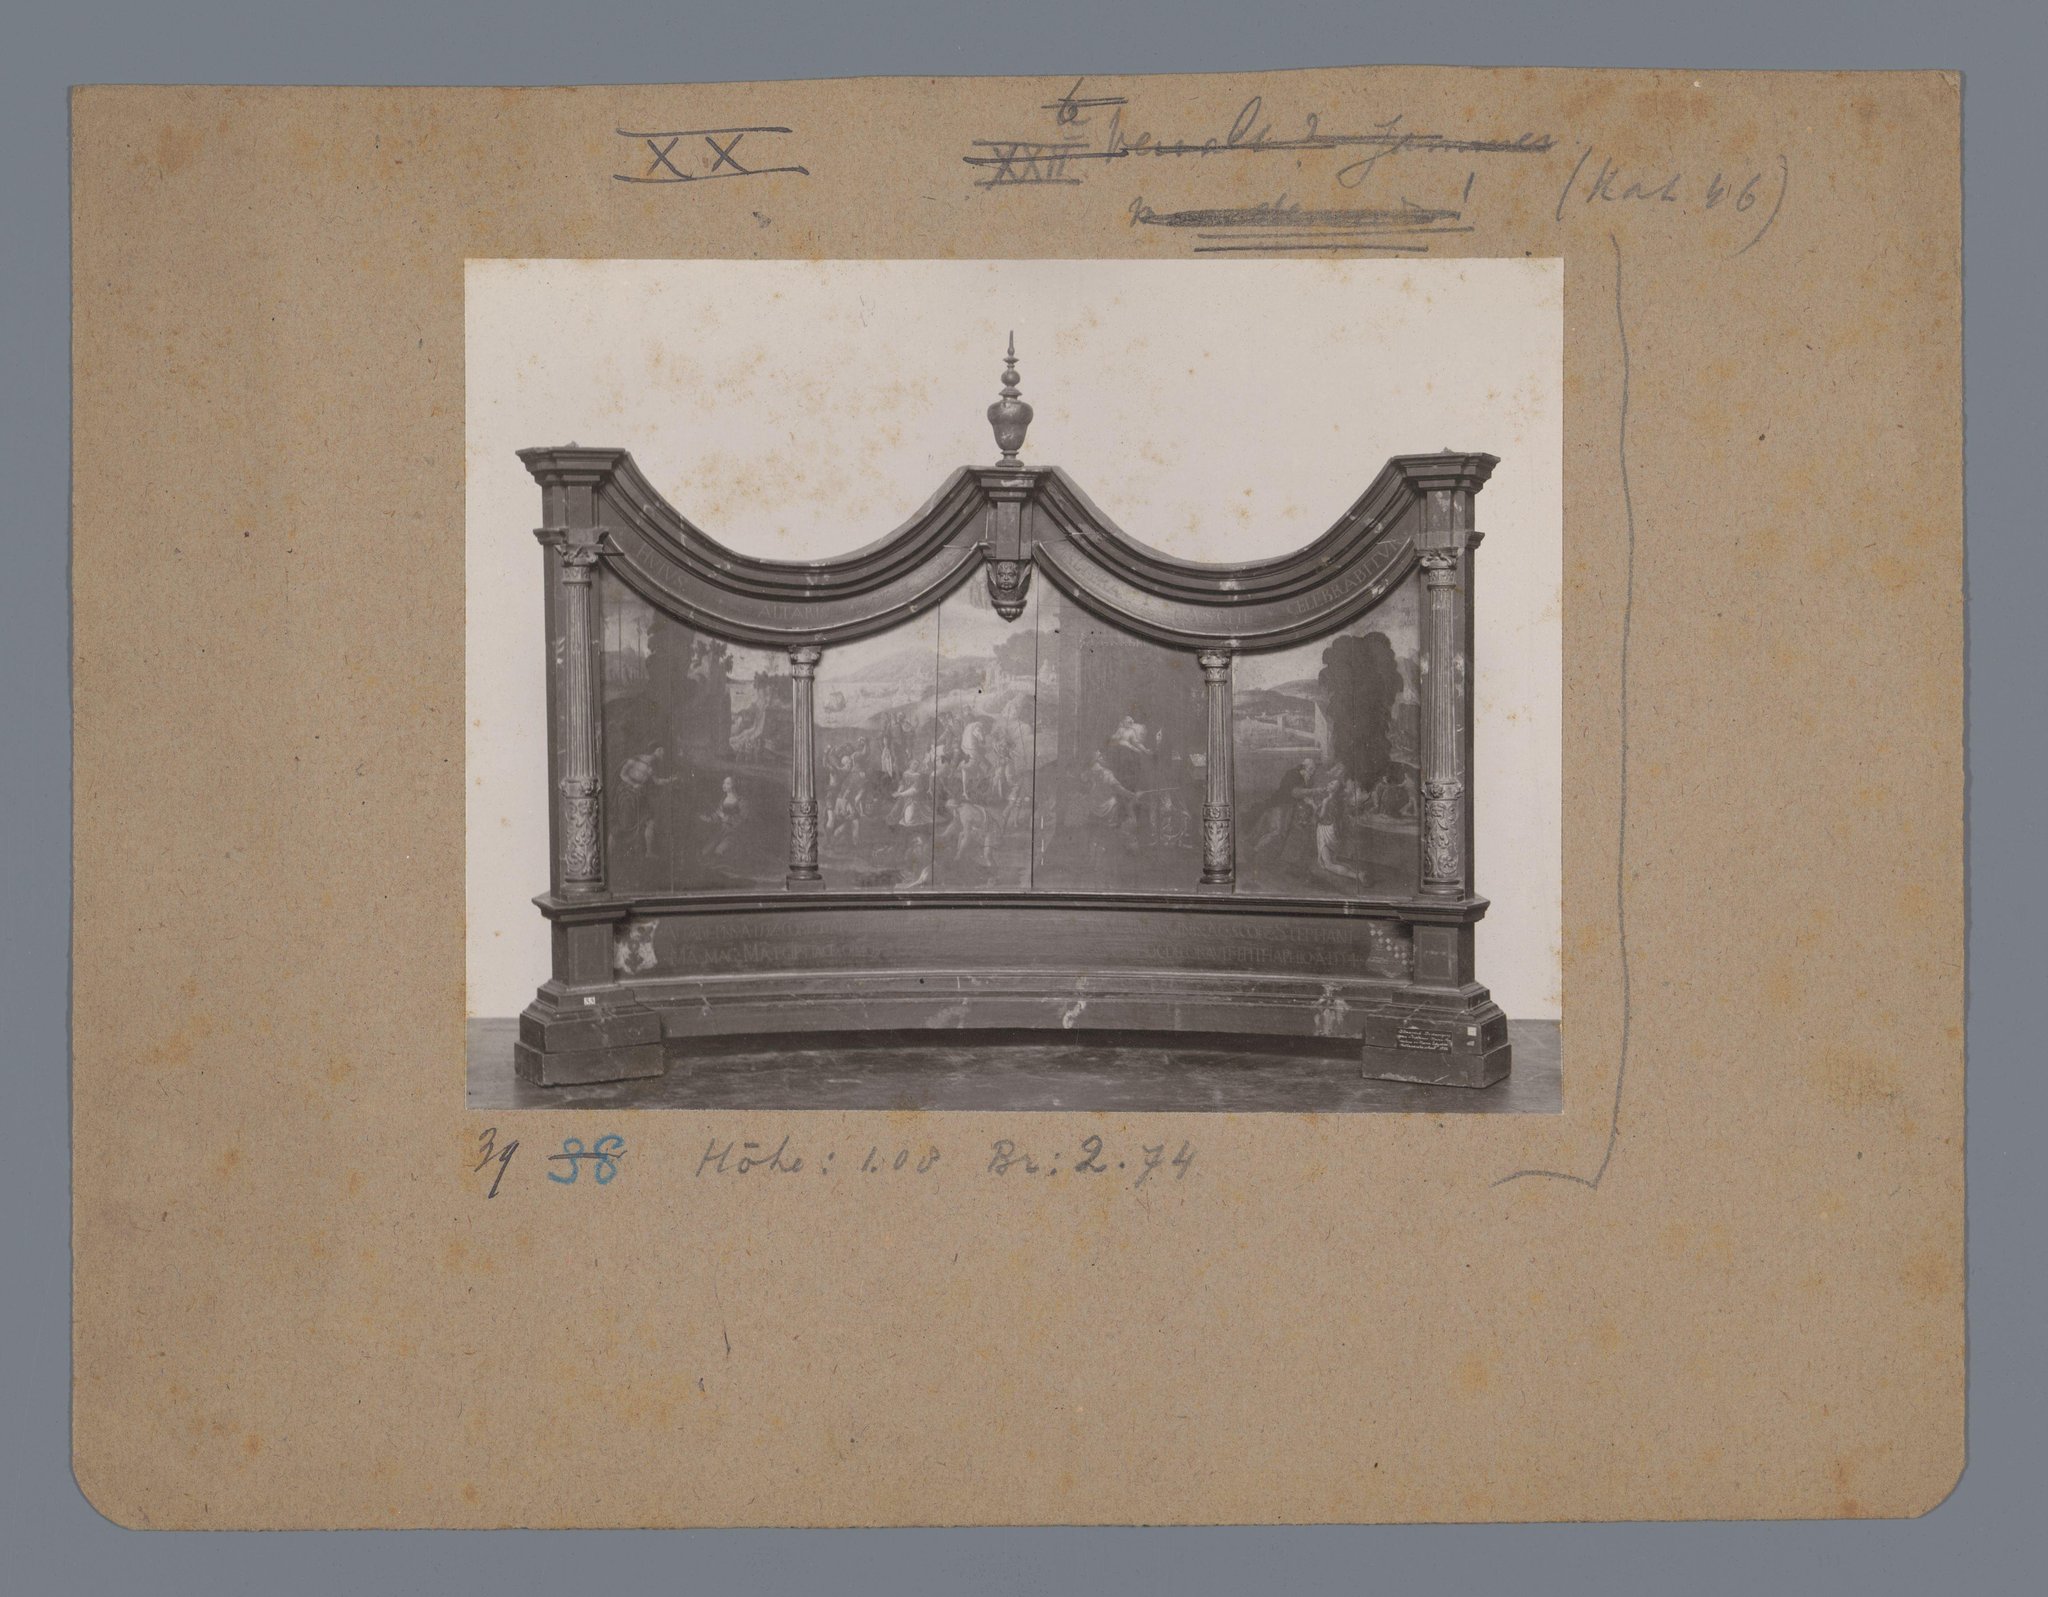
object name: photograph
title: Drieluik met de steniging van Stephanus en de legende van het vinden van zijn graf in het Rijksmuseum te Amsterdam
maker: Anonymous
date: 1875-1900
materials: paper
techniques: carbon print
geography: amsterdam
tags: the stoning of stephen; the witnesses lay down their clothes at saul's feet, picture, painting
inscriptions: collector's mark: ‘Kunstnijverheidschool Quellinus Amsterdam Frans Halsstraat 14.’, collector's mark: ‘Instituut voor kunst-nijverheidsonderwijs Gabriël Metsustraat No. 16, Amsterdam’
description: Zie voor het originele object SK-A-4486.